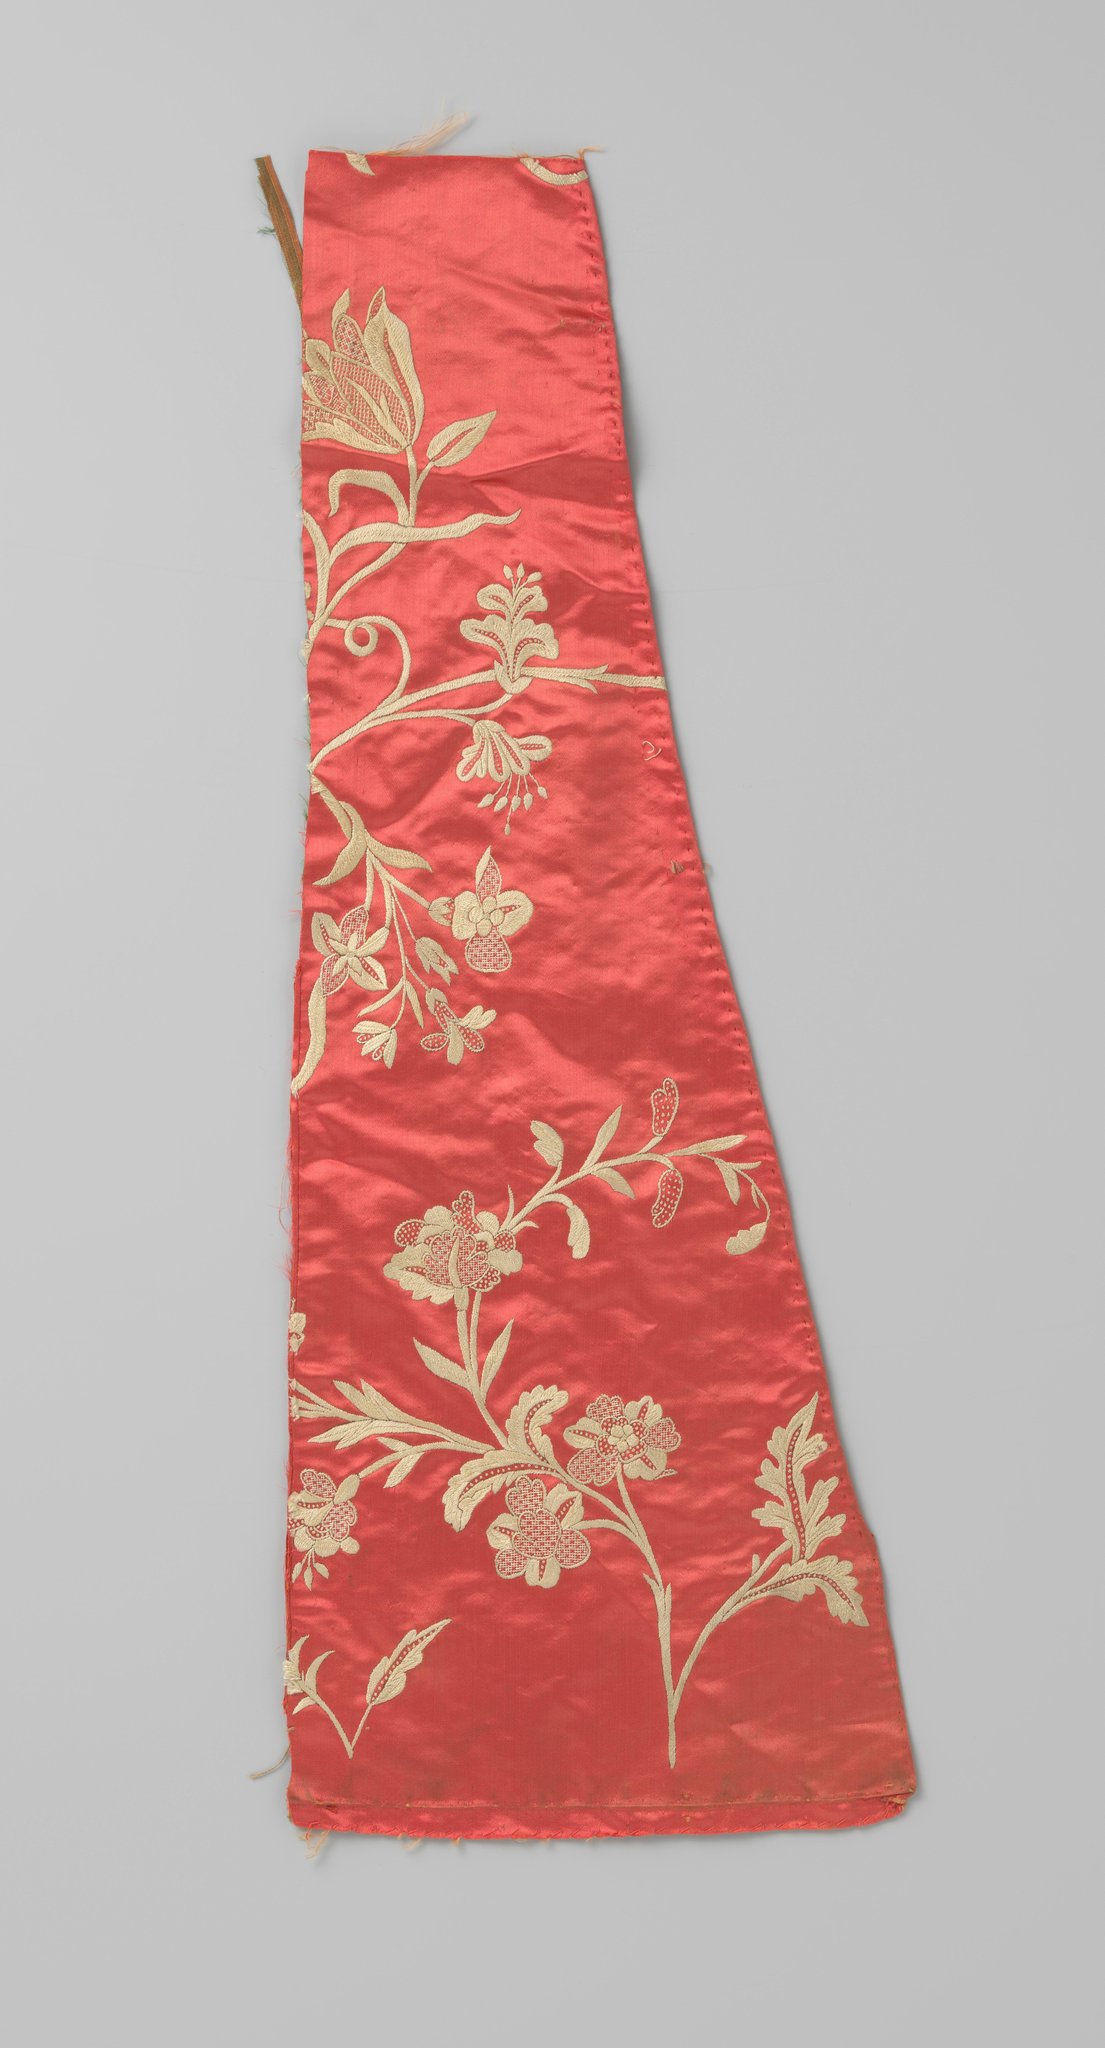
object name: cloth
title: Embroidered Interior Textile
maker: Anonymous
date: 1750-1760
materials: silk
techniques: embroidered, weave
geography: france